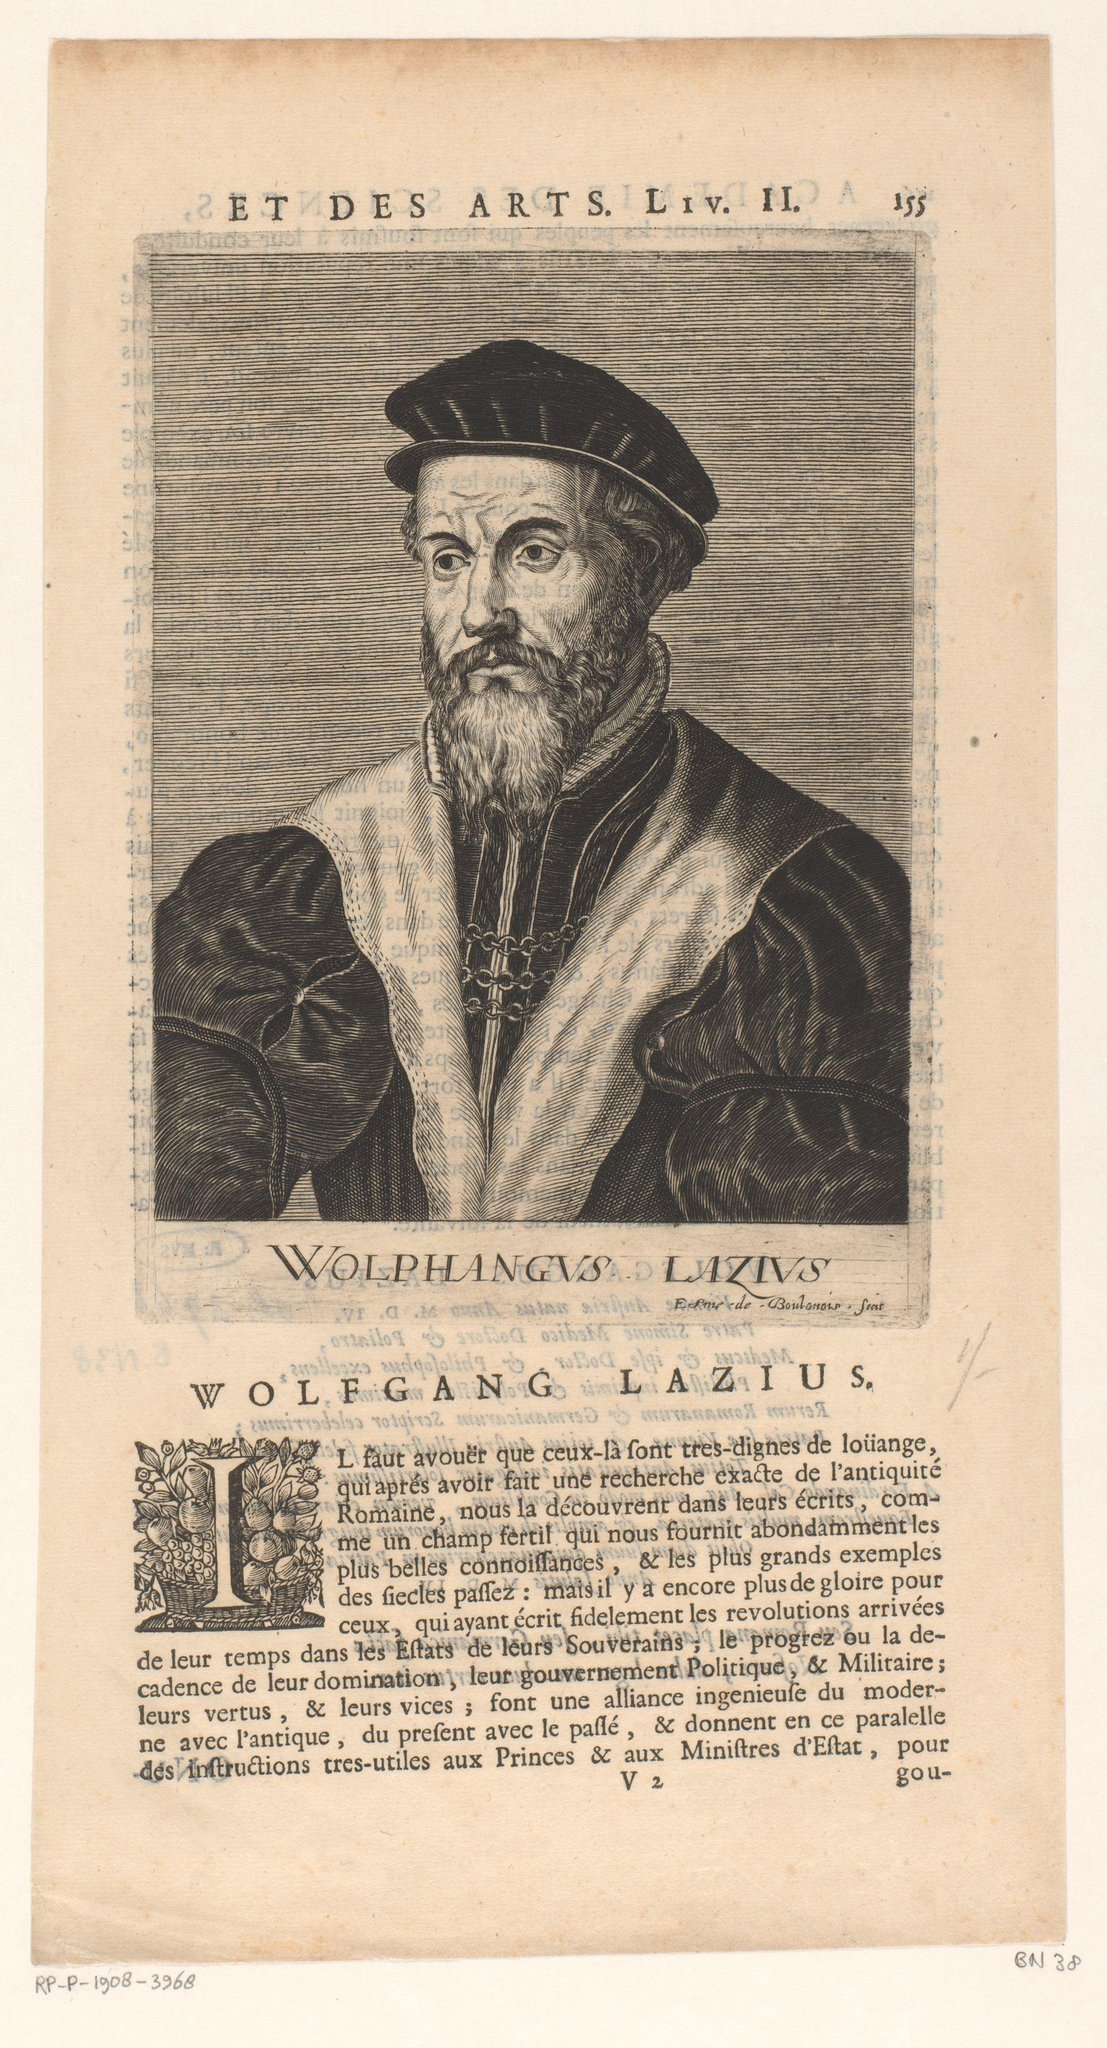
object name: print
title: Wolphangus Lazius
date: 1682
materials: paper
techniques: engraving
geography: brussels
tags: vienna, wolfgang lazius, historical persons, physician, doctor, professor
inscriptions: collector's mark: Lugt 2228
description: Prent uit: Bullert, Isaac. Académie des Sciences et Arts contenant les vies et éloges his. des hommes illustres qui ont excellé en ces professions depuis environ quatre siècles. Brussel: Foppens, François, 1682. Het boek werd in 1682 eveneens in Amsterdam uitgegeven door de erfgenamen van Daniel Elzevier. Deze portretten dienen ter illustratie van de biografie van een kunstenaar of geleerde. De meeste portretten werden door Nicolas de Larmessin vervaardigd (162), 93 door De Boulonois en een derde door ongeïdentificeerde prentmakers. Dit betreft een illustratie op p. 155, deel I.